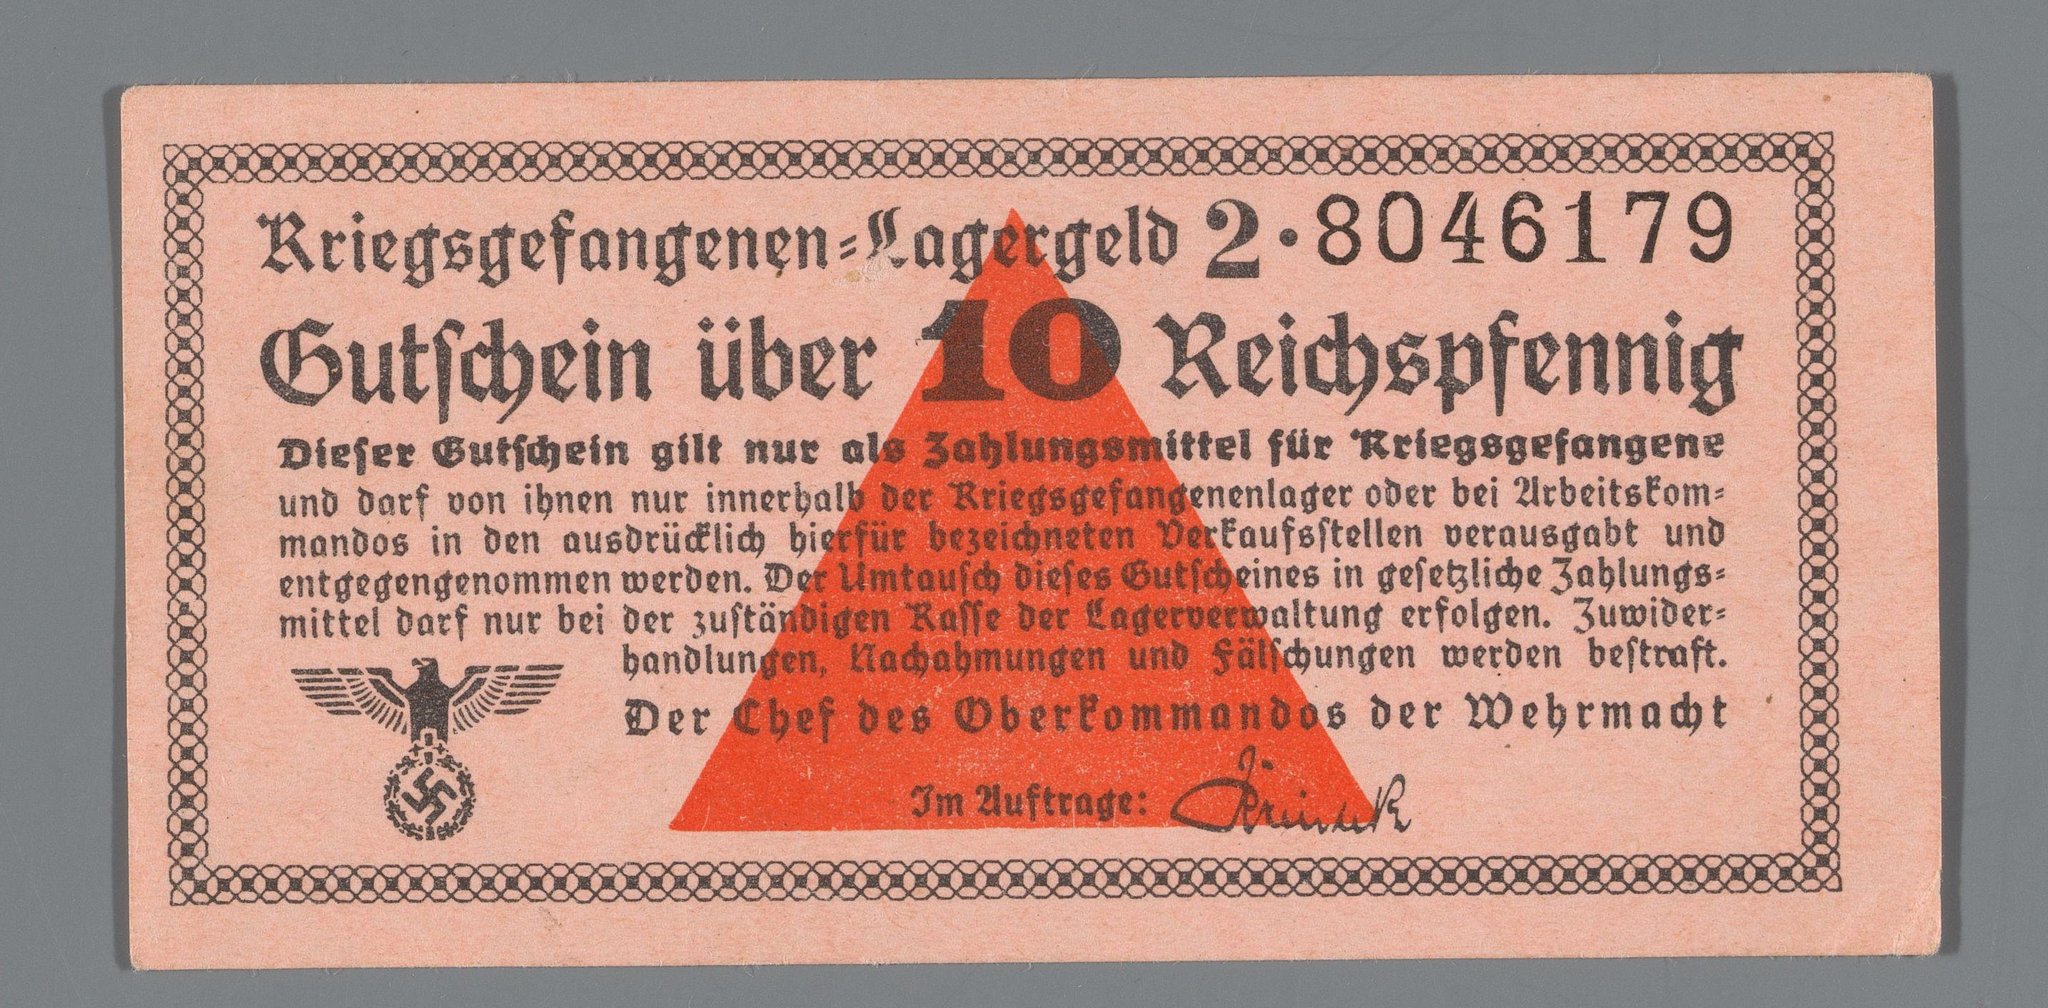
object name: tien reichspfennig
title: Biljet van tien reichspfennig, kampgeld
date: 1944-1945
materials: paper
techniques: printing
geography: germany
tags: mühlberg, tweede wereldoorlog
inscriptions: inscription: ‘Kriegsgevangenen Lagergeld -2- 8046179 Gutschein über 10 Reichspfenning’, signature: ‘Der Chef des Oberkommandos der Wehrmacht’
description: Roze papier met rode driehoek en zwarte letters. "Kriegsgevangenen Lagergeld -2- 8046179 Gutschein über 10 Reichspfennig". Dan verhaal over wat wel en niet mag met het geld. Adelaar met hakenkruis. Ondertekend: Der Chef des Oberkommandos der Wehrmacht, Im Auftrage: ?. Achterkant blanco.